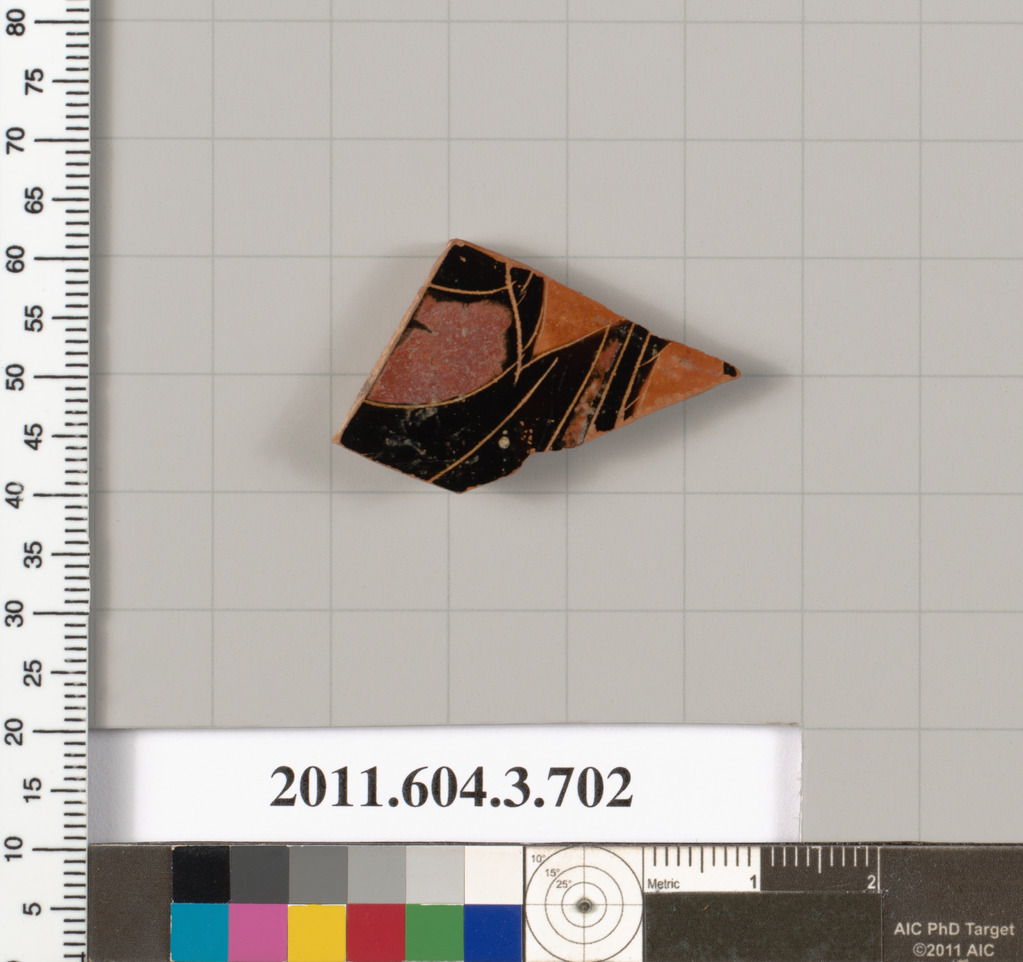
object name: hydria fragment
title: Terracotta fragment of a hydria (water jar)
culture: greek, attic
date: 525-501 BCE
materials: terracotta